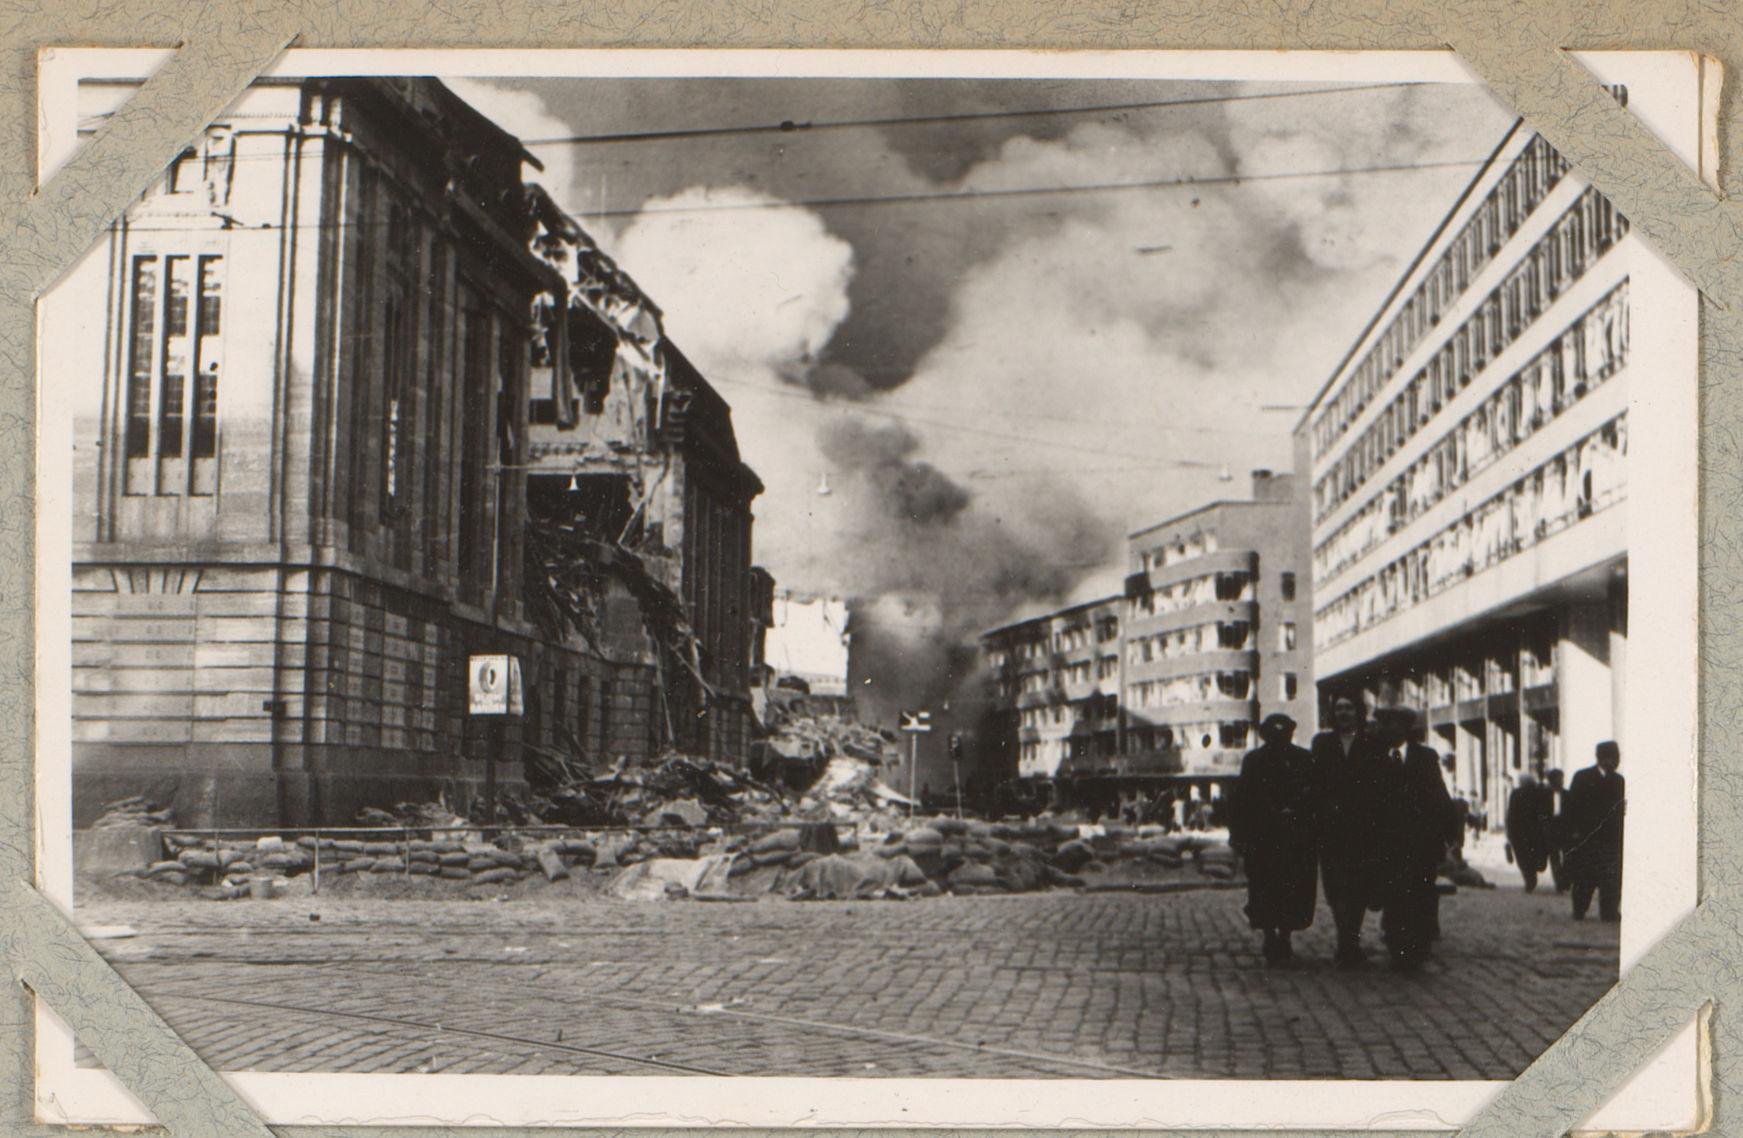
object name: photograph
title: Gezicht op de Meent te Rotterdam met rookwolken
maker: j. nolte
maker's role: fotograaf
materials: photographic support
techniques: gelatin silver print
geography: rotterdam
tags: on fire, ablaze, devastated, ruined place or city (~ warfare), street, rotterdam, rotterdam blitz